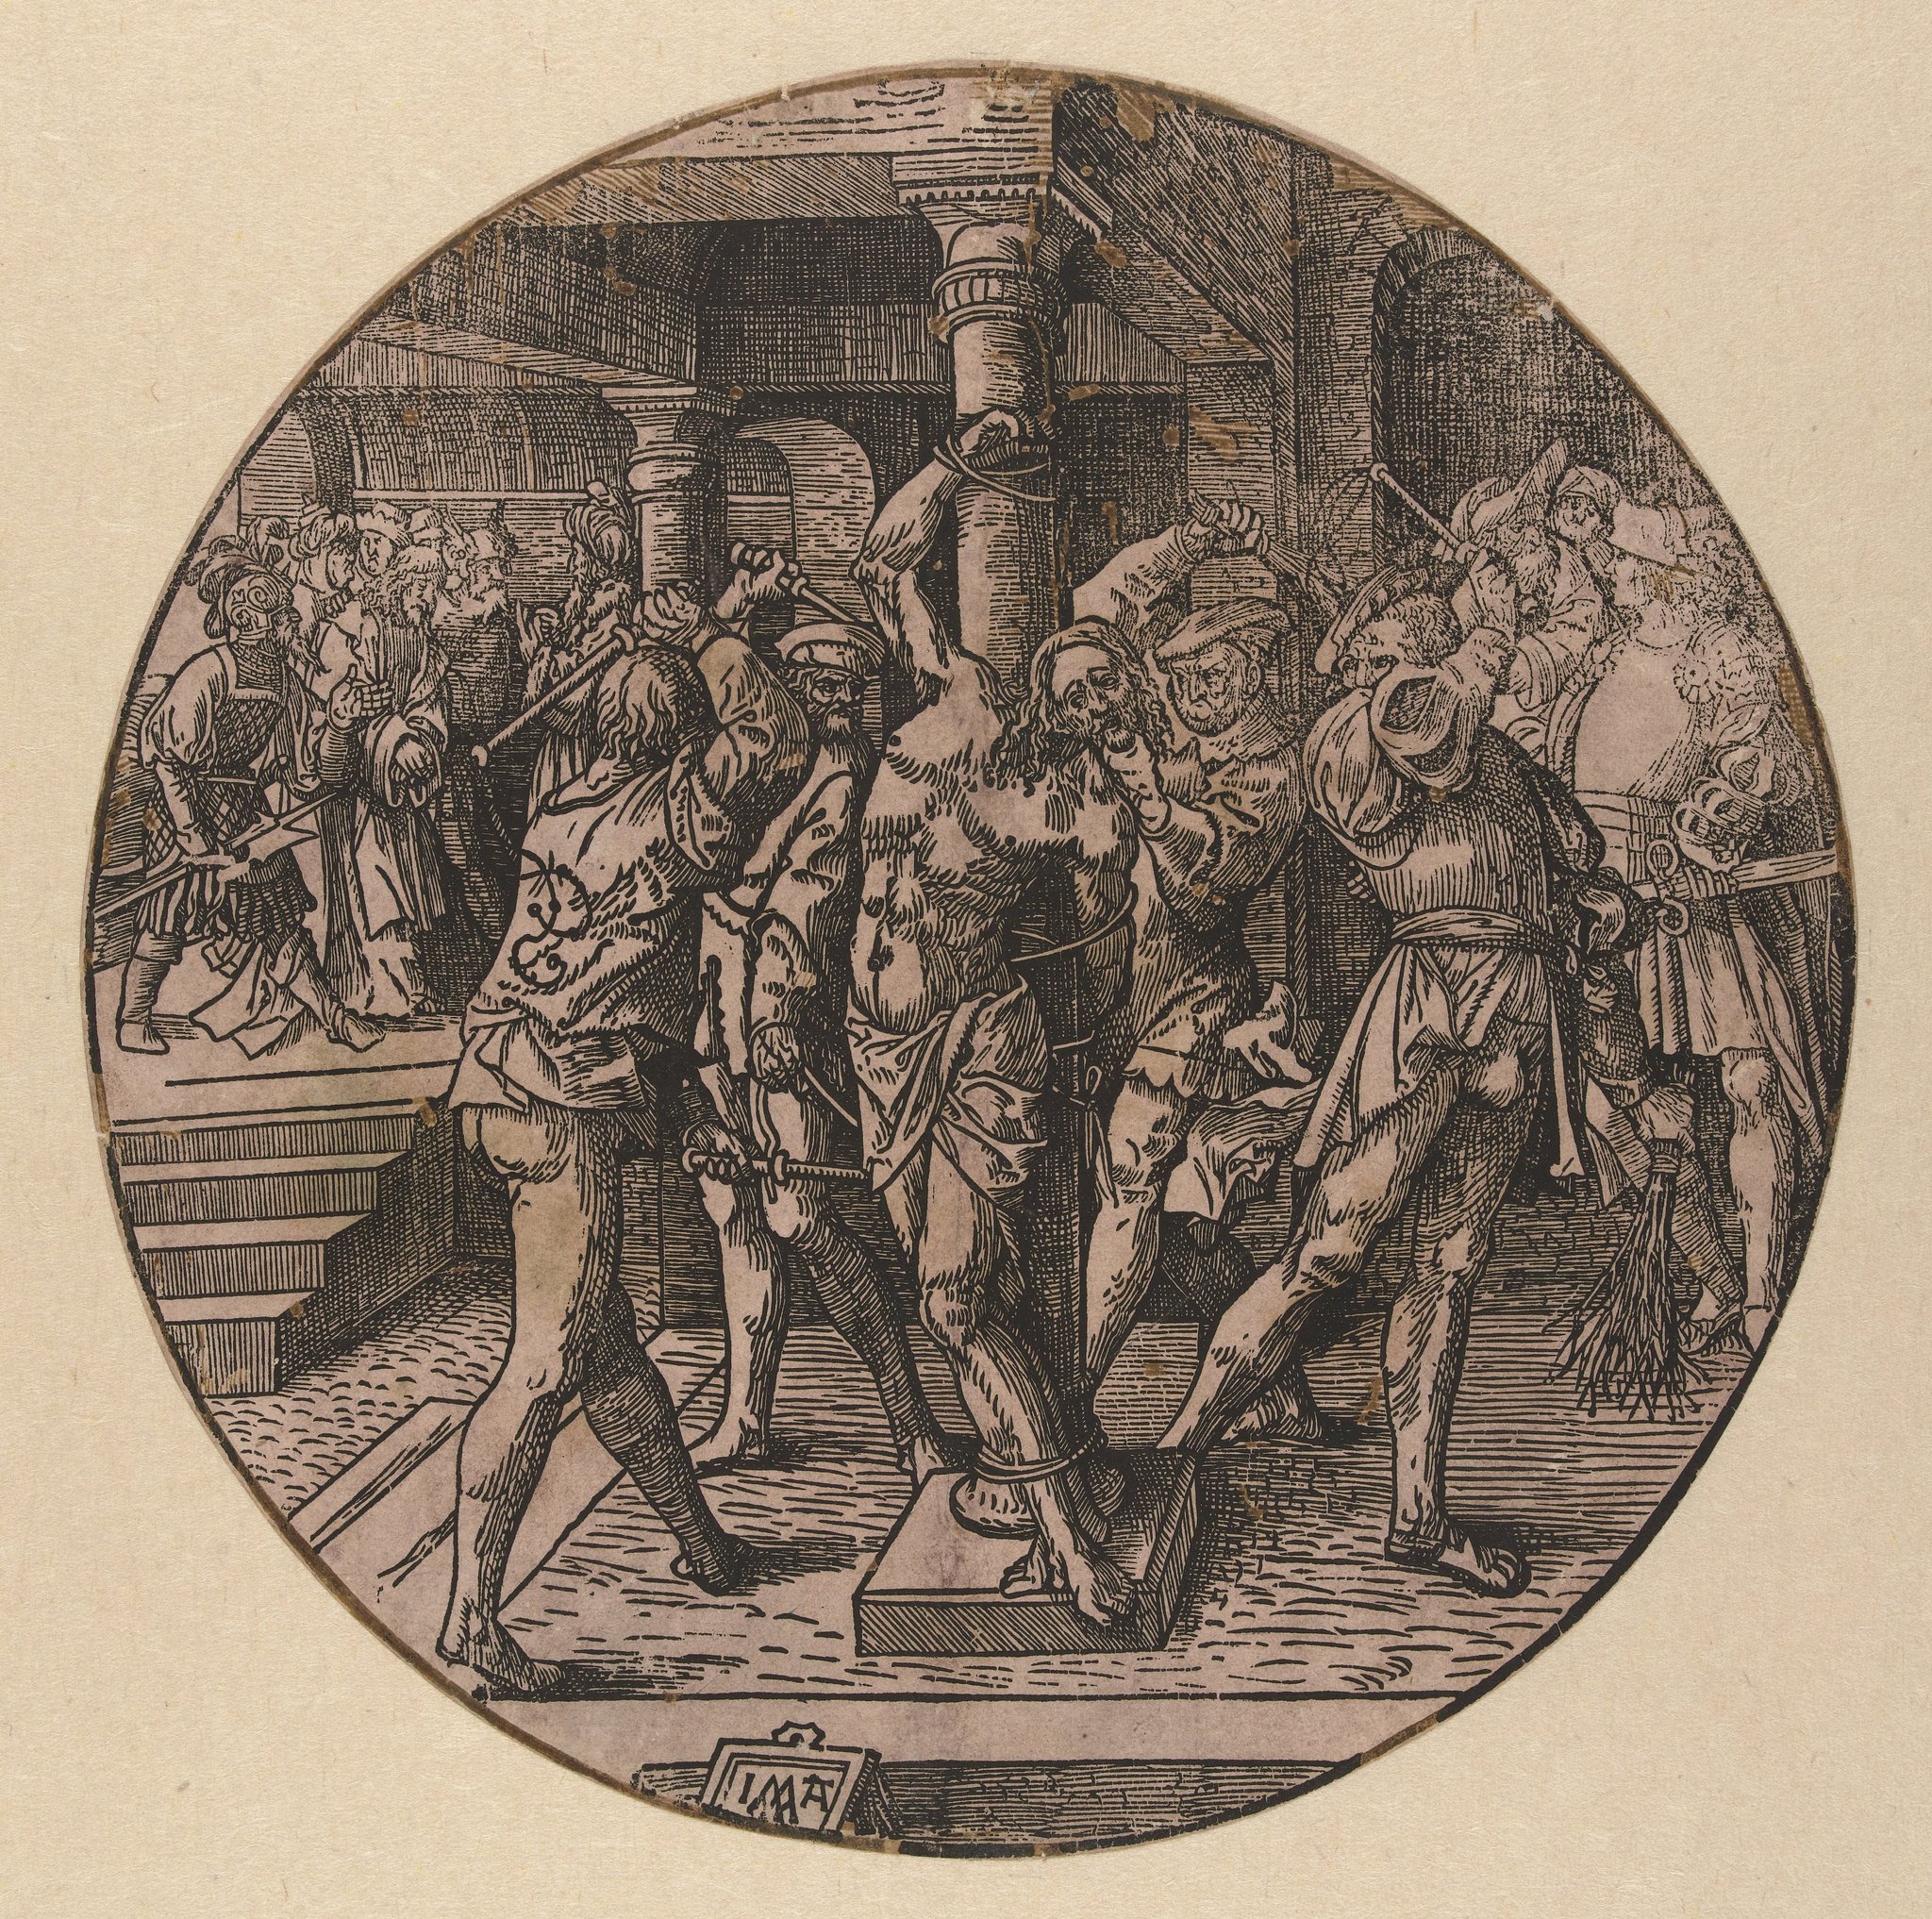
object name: print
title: Geseling van Christus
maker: jacob cornelisz van oostsanen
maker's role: draughtsman, painter, print maker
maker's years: 1475-1533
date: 1517-1533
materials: paper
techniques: pen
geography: low countries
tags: flagellation by soldiers, christ usually tied to a column (matthew 27:26; mark 15:15; john 19:1)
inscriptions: collector's mark: Lugt 2165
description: Uit serie van twaalf prenten. Omlijsting weggesneden. Christus, vastgebonden aan zuil, door vier mannen met zwepen geslagen.